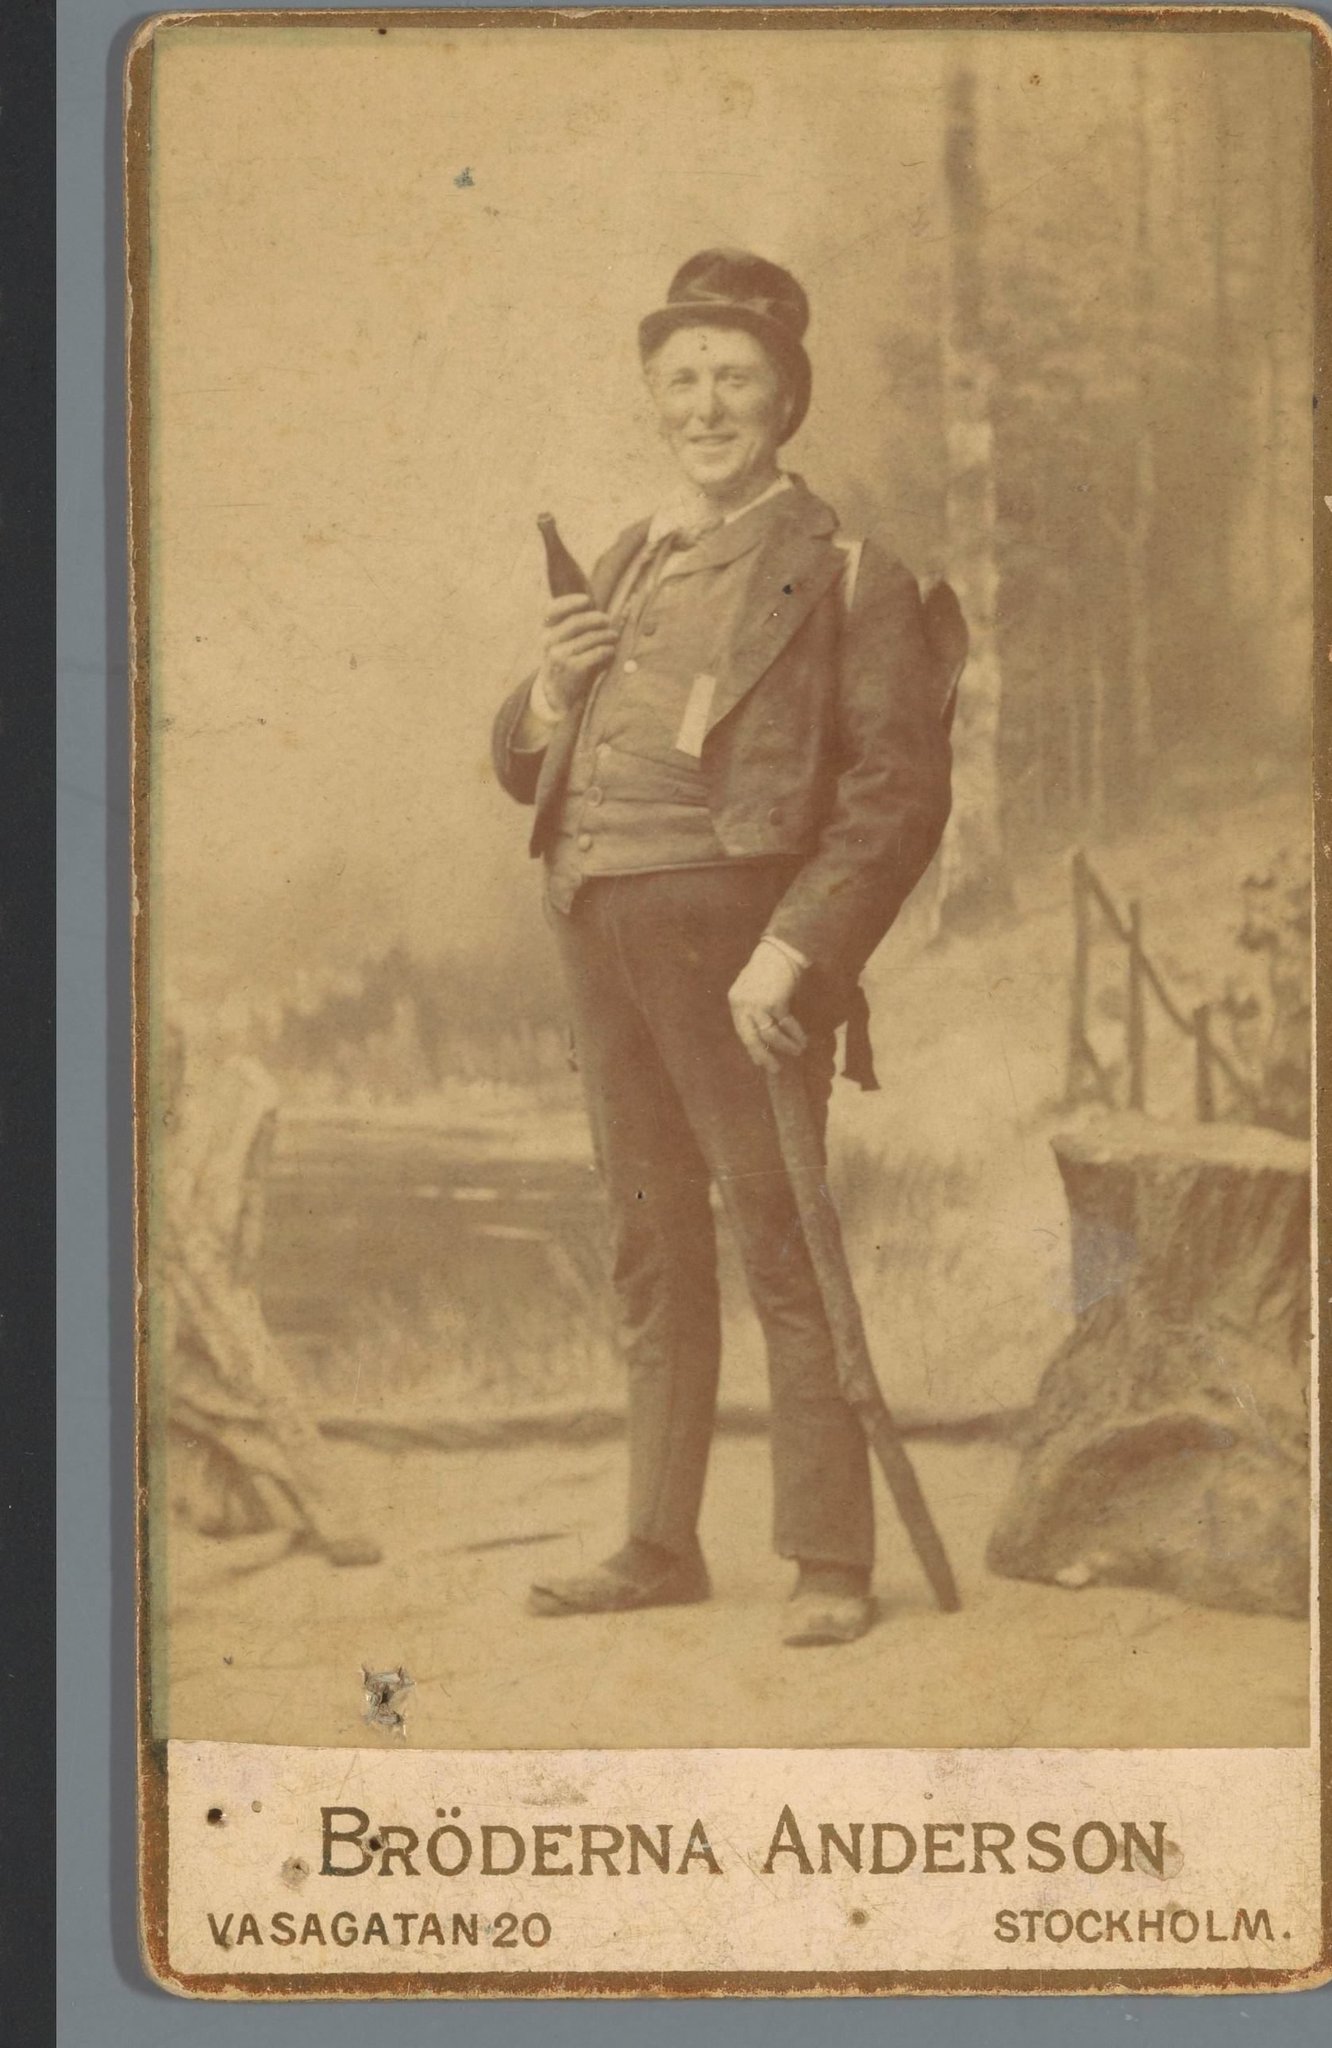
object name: carte de visite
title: Portret van een onbekende man verkleed als landloper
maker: bröderna anderson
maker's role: fotograaf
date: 1880-1897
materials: cardboard, paper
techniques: albumen print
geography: stockholm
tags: adult man, anonymous historical person portrayed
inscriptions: address: ‘Stockholm/ Vasagatan 20/ midt emot Centralstationen.’, inscription: ‘Plåten förvaras för efterbeställning.’